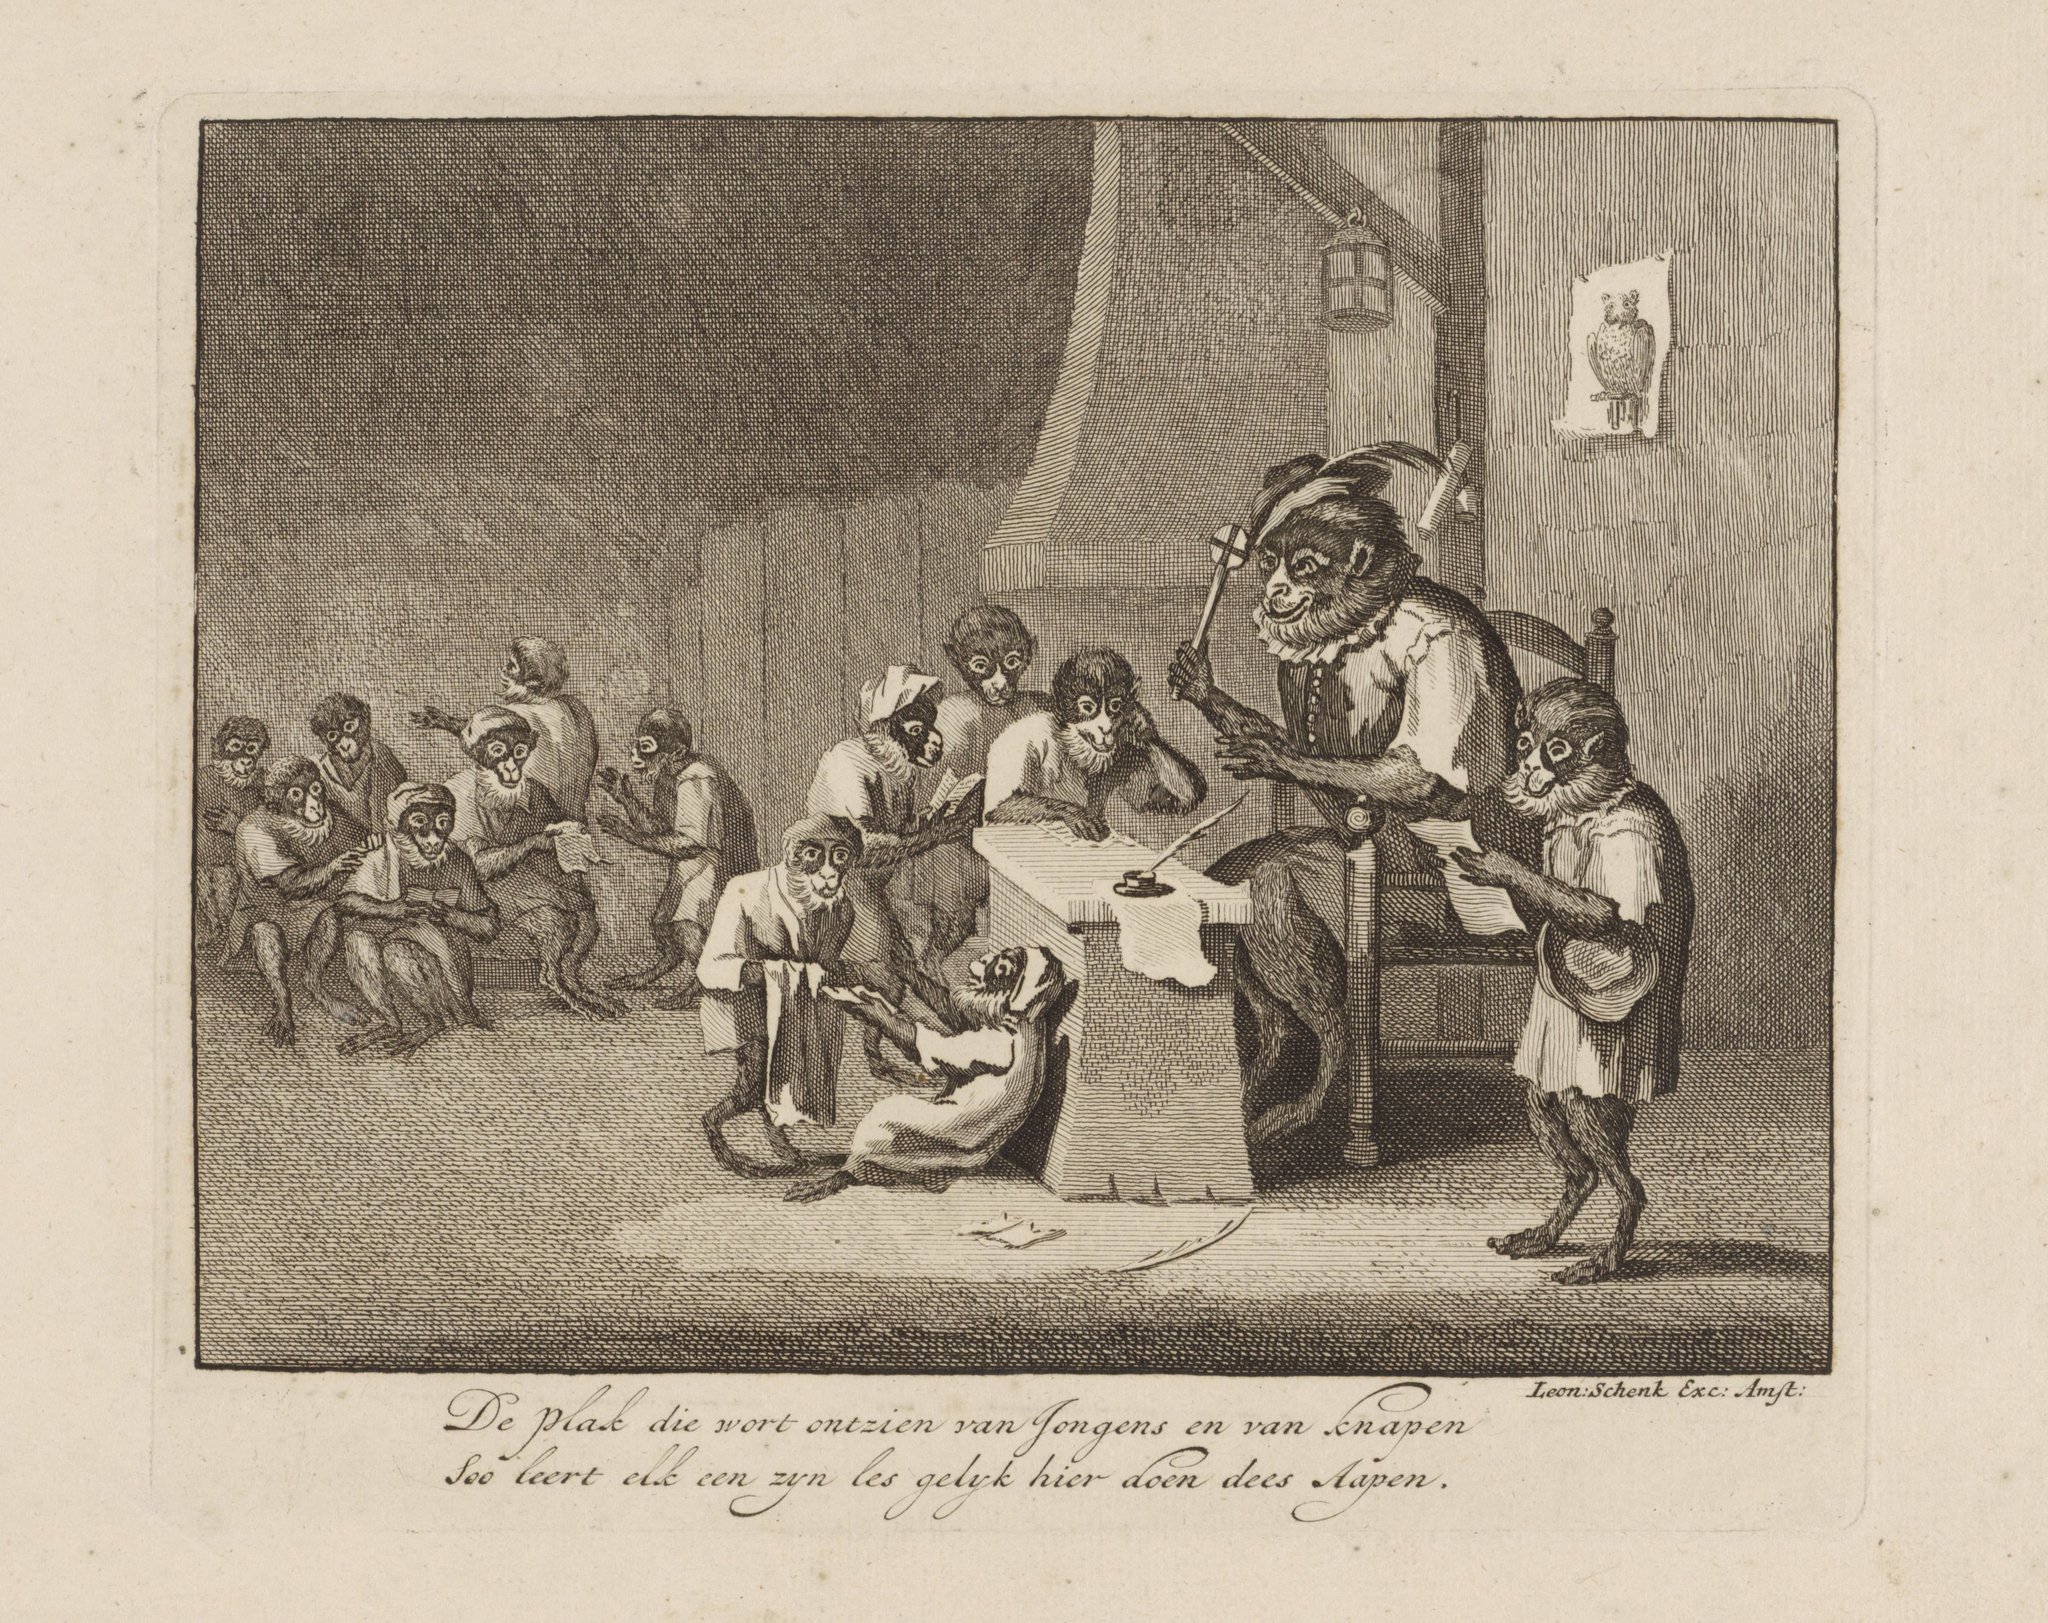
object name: print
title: Apenspel in de wereld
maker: leonard schenk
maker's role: print maker, publisher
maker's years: 1696-1767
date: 1720-1767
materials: paper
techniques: etching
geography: amsterdam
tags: monkeys, apes, animals acting as human beings, corporal punishment at school: castigating, beating, etc., elementary school; class, form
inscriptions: collector's mark: Lugt 2228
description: In een klaslokaal met leerlingen zit een aap als schoolmeester achter zijn bank. Op de bank staat een inktpot, De schoolmeester heeft een plak in zijn hand en de leerling naast hem heeft zijn hand al op de bank gelegd. Aan de muur hangt een afbeelding van een uil. Onderdeel van een serie bestaande uit een titelprent en platen waarin apen als mensen figureren in allerlei taferelen uit het dagelijks leven. De prent heeft een tweeregelig vers in het Nederlands.